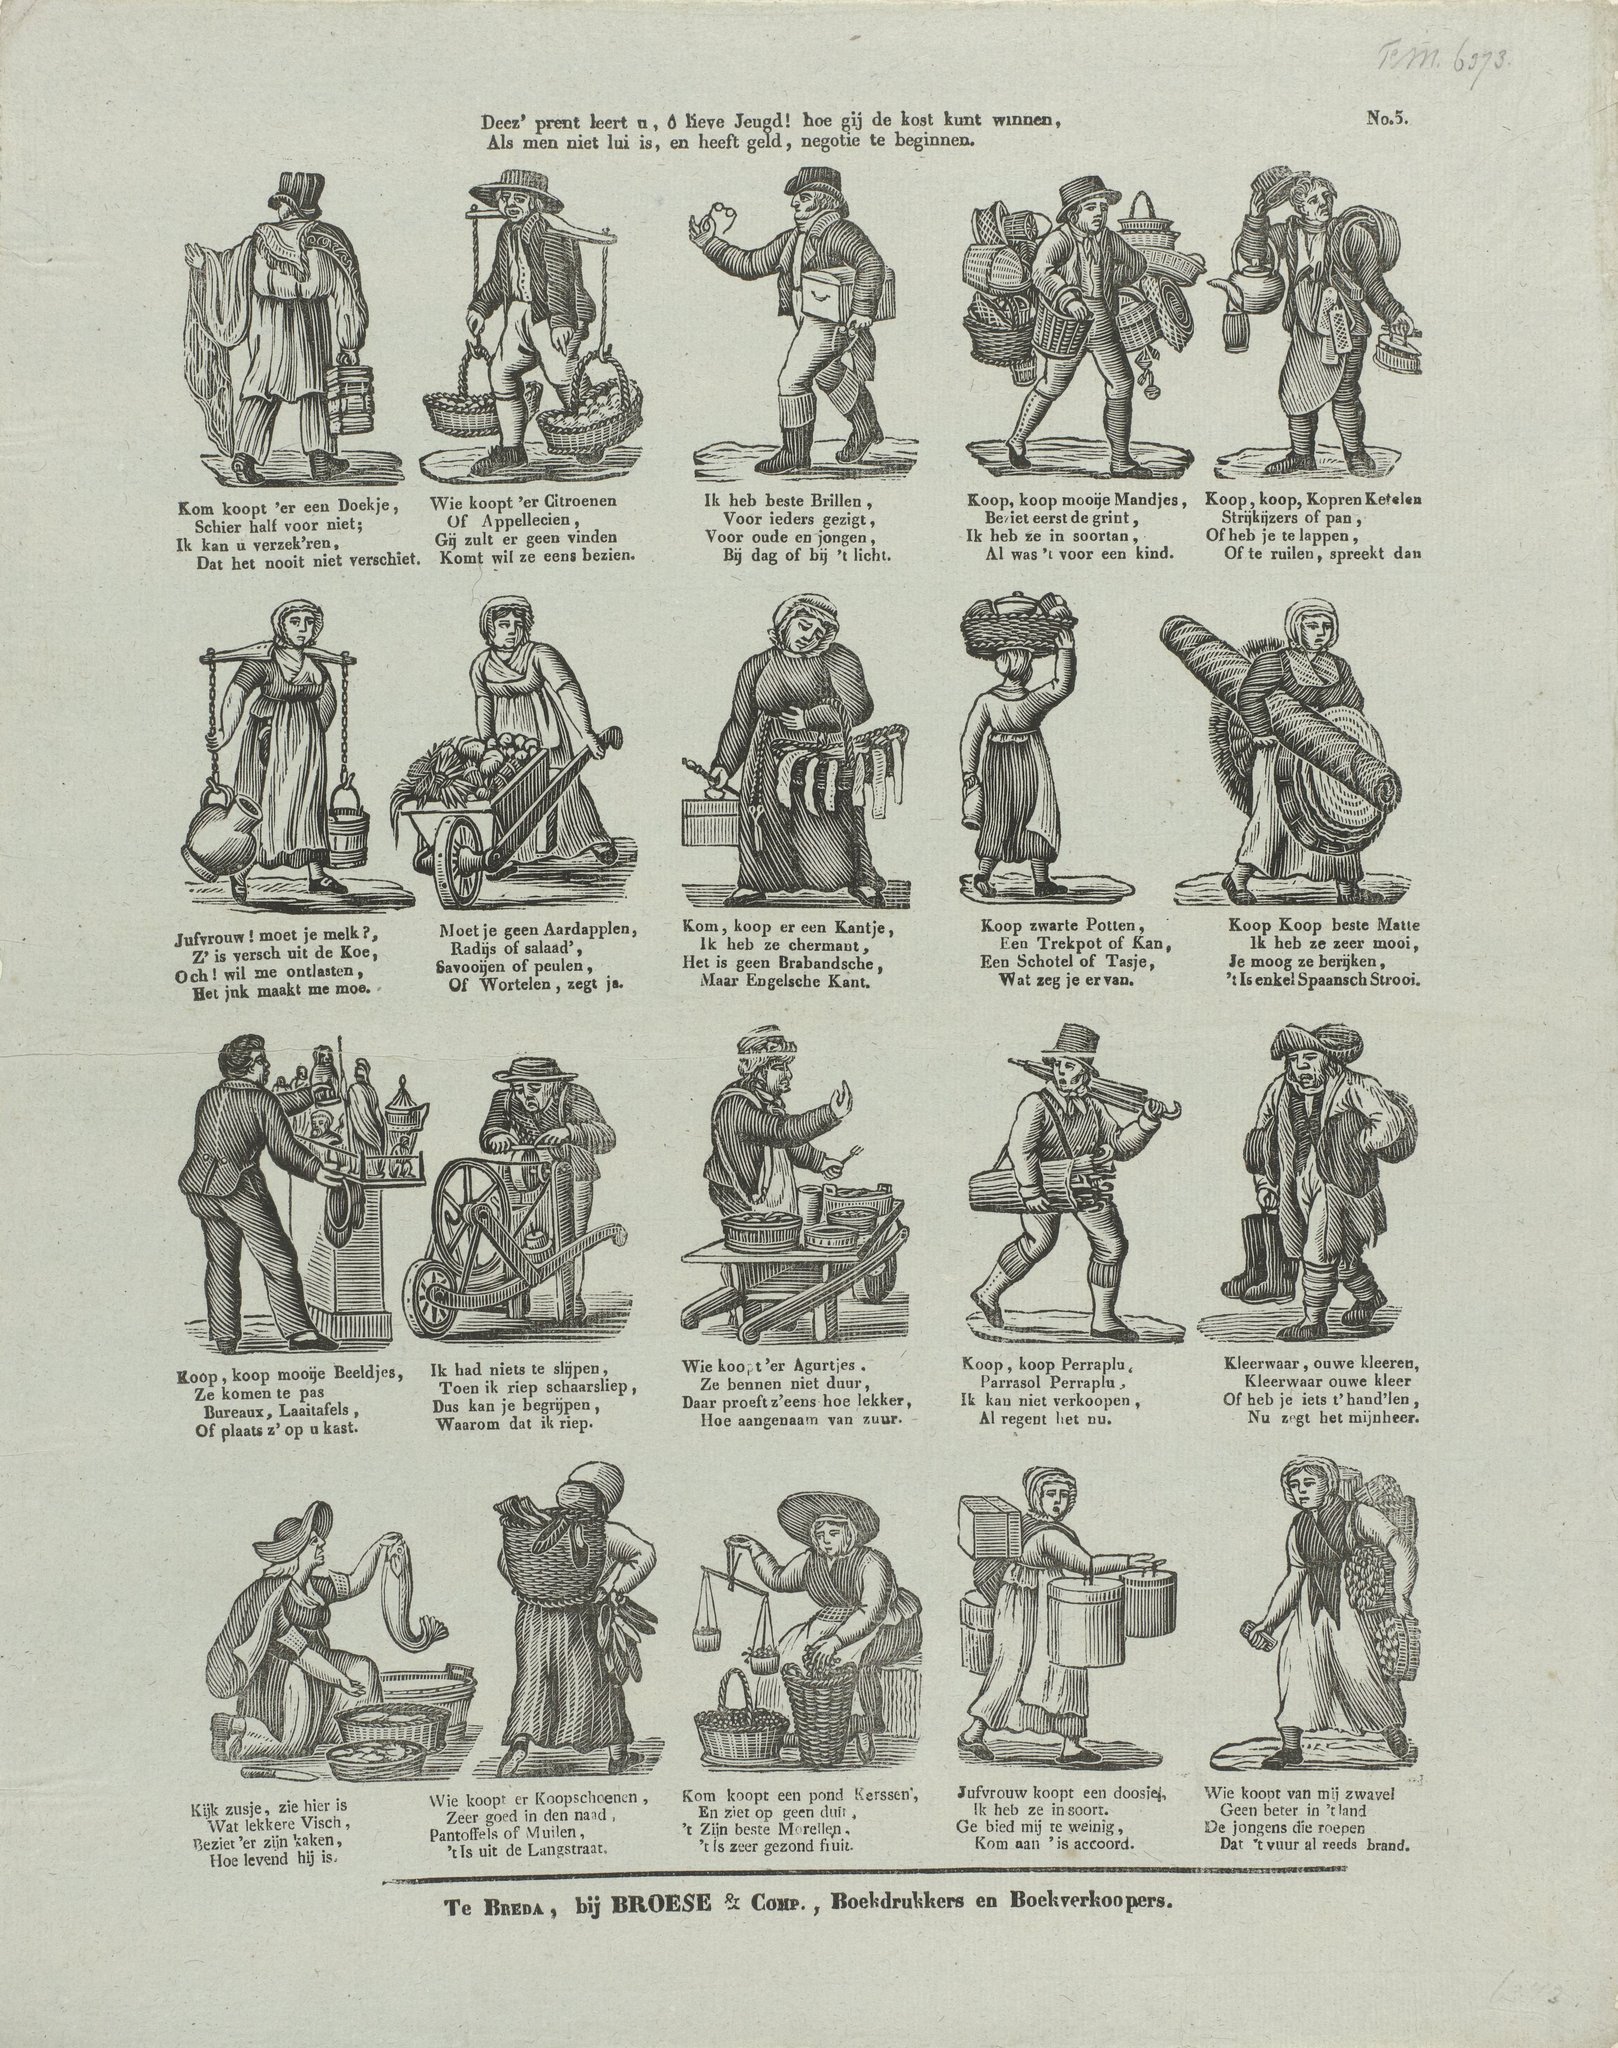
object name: popular print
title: Deez' prent leert u o lieve jeugd! hoe gij uw kost kunt winnen, / Als men niet lui is, en heeft geld, negotie te beginnen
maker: Anonymous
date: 1828-1853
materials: paper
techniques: letterpress printing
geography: breda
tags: street-trader, crafts and industries, merchant, salesman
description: Blad met 20 voorstellingen van ambachtslieden en beroepen, zoals brillenverkoper, koeienmelkster, mattenverkoopster en schoenenverkoopster. Onder elke voorstelling een vierregelig vers. Genummerd rechtsboven: No. 5.